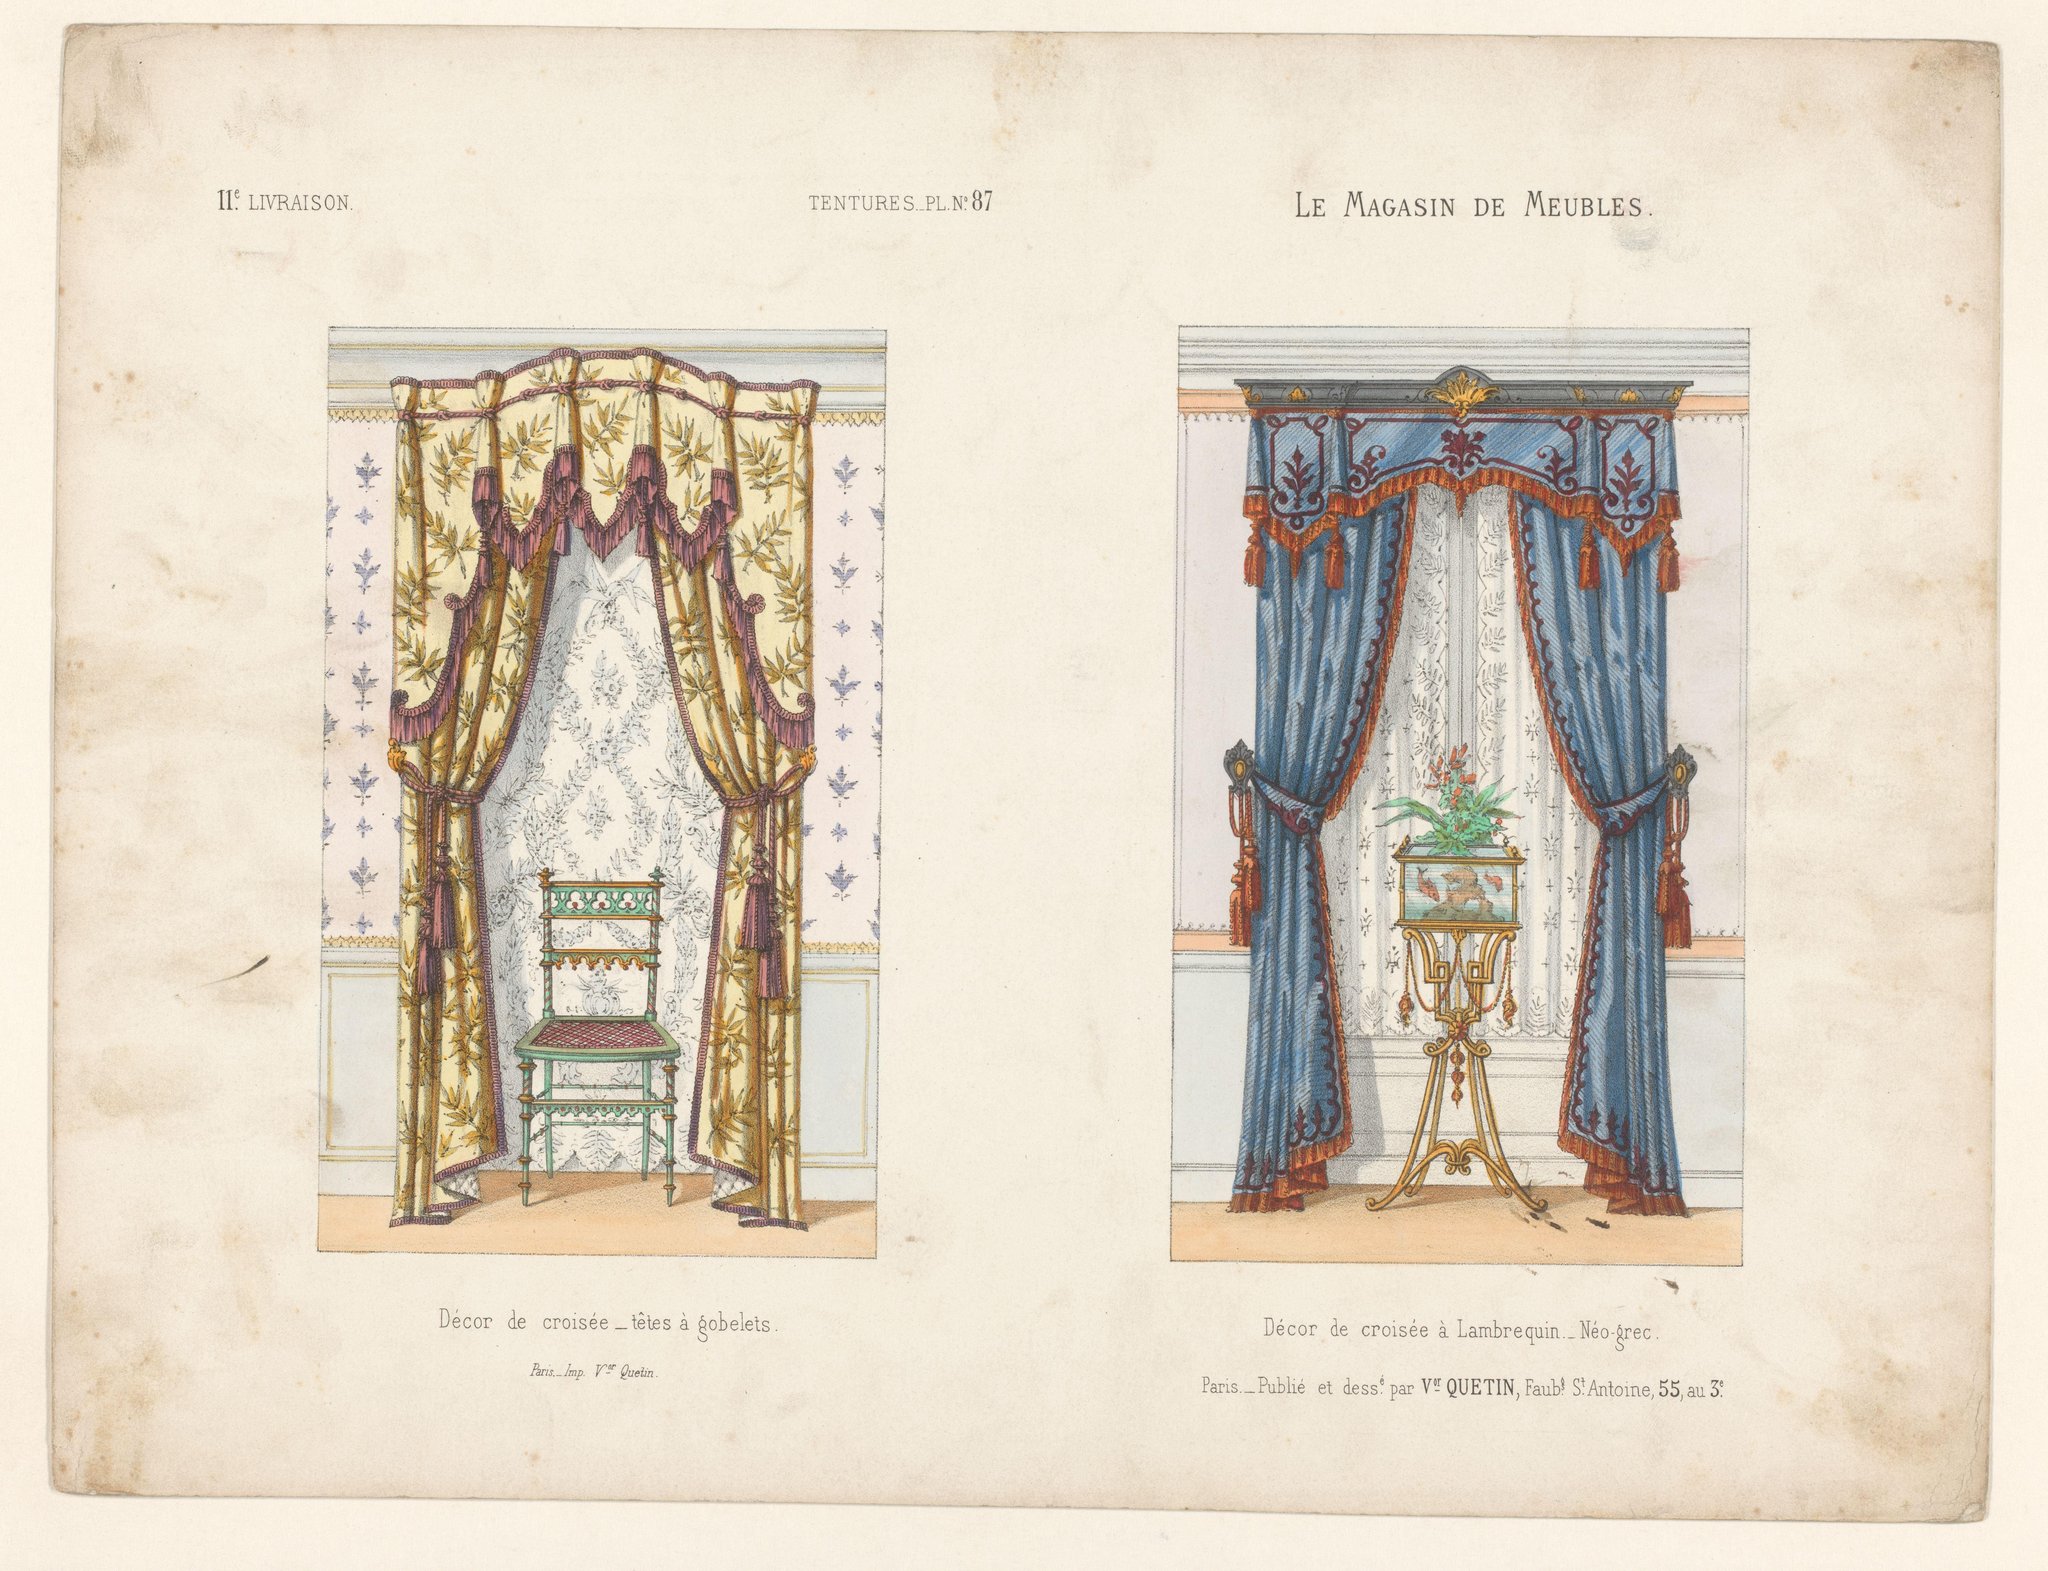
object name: print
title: Décor de croisée têtes à gobelets / Décor de croisée à Lambrequin. Néo-grec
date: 1832-1877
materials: paper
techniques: hand coloring, lithograph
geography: paris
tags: window, hangings and drapery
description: Twee vensters met gedrapeerde gordijnen, waarvan één in de stijl van de neo-grec. Voor de vensters staan een stoel en vissenkom op standaard. Prent uit 11e Livraison.